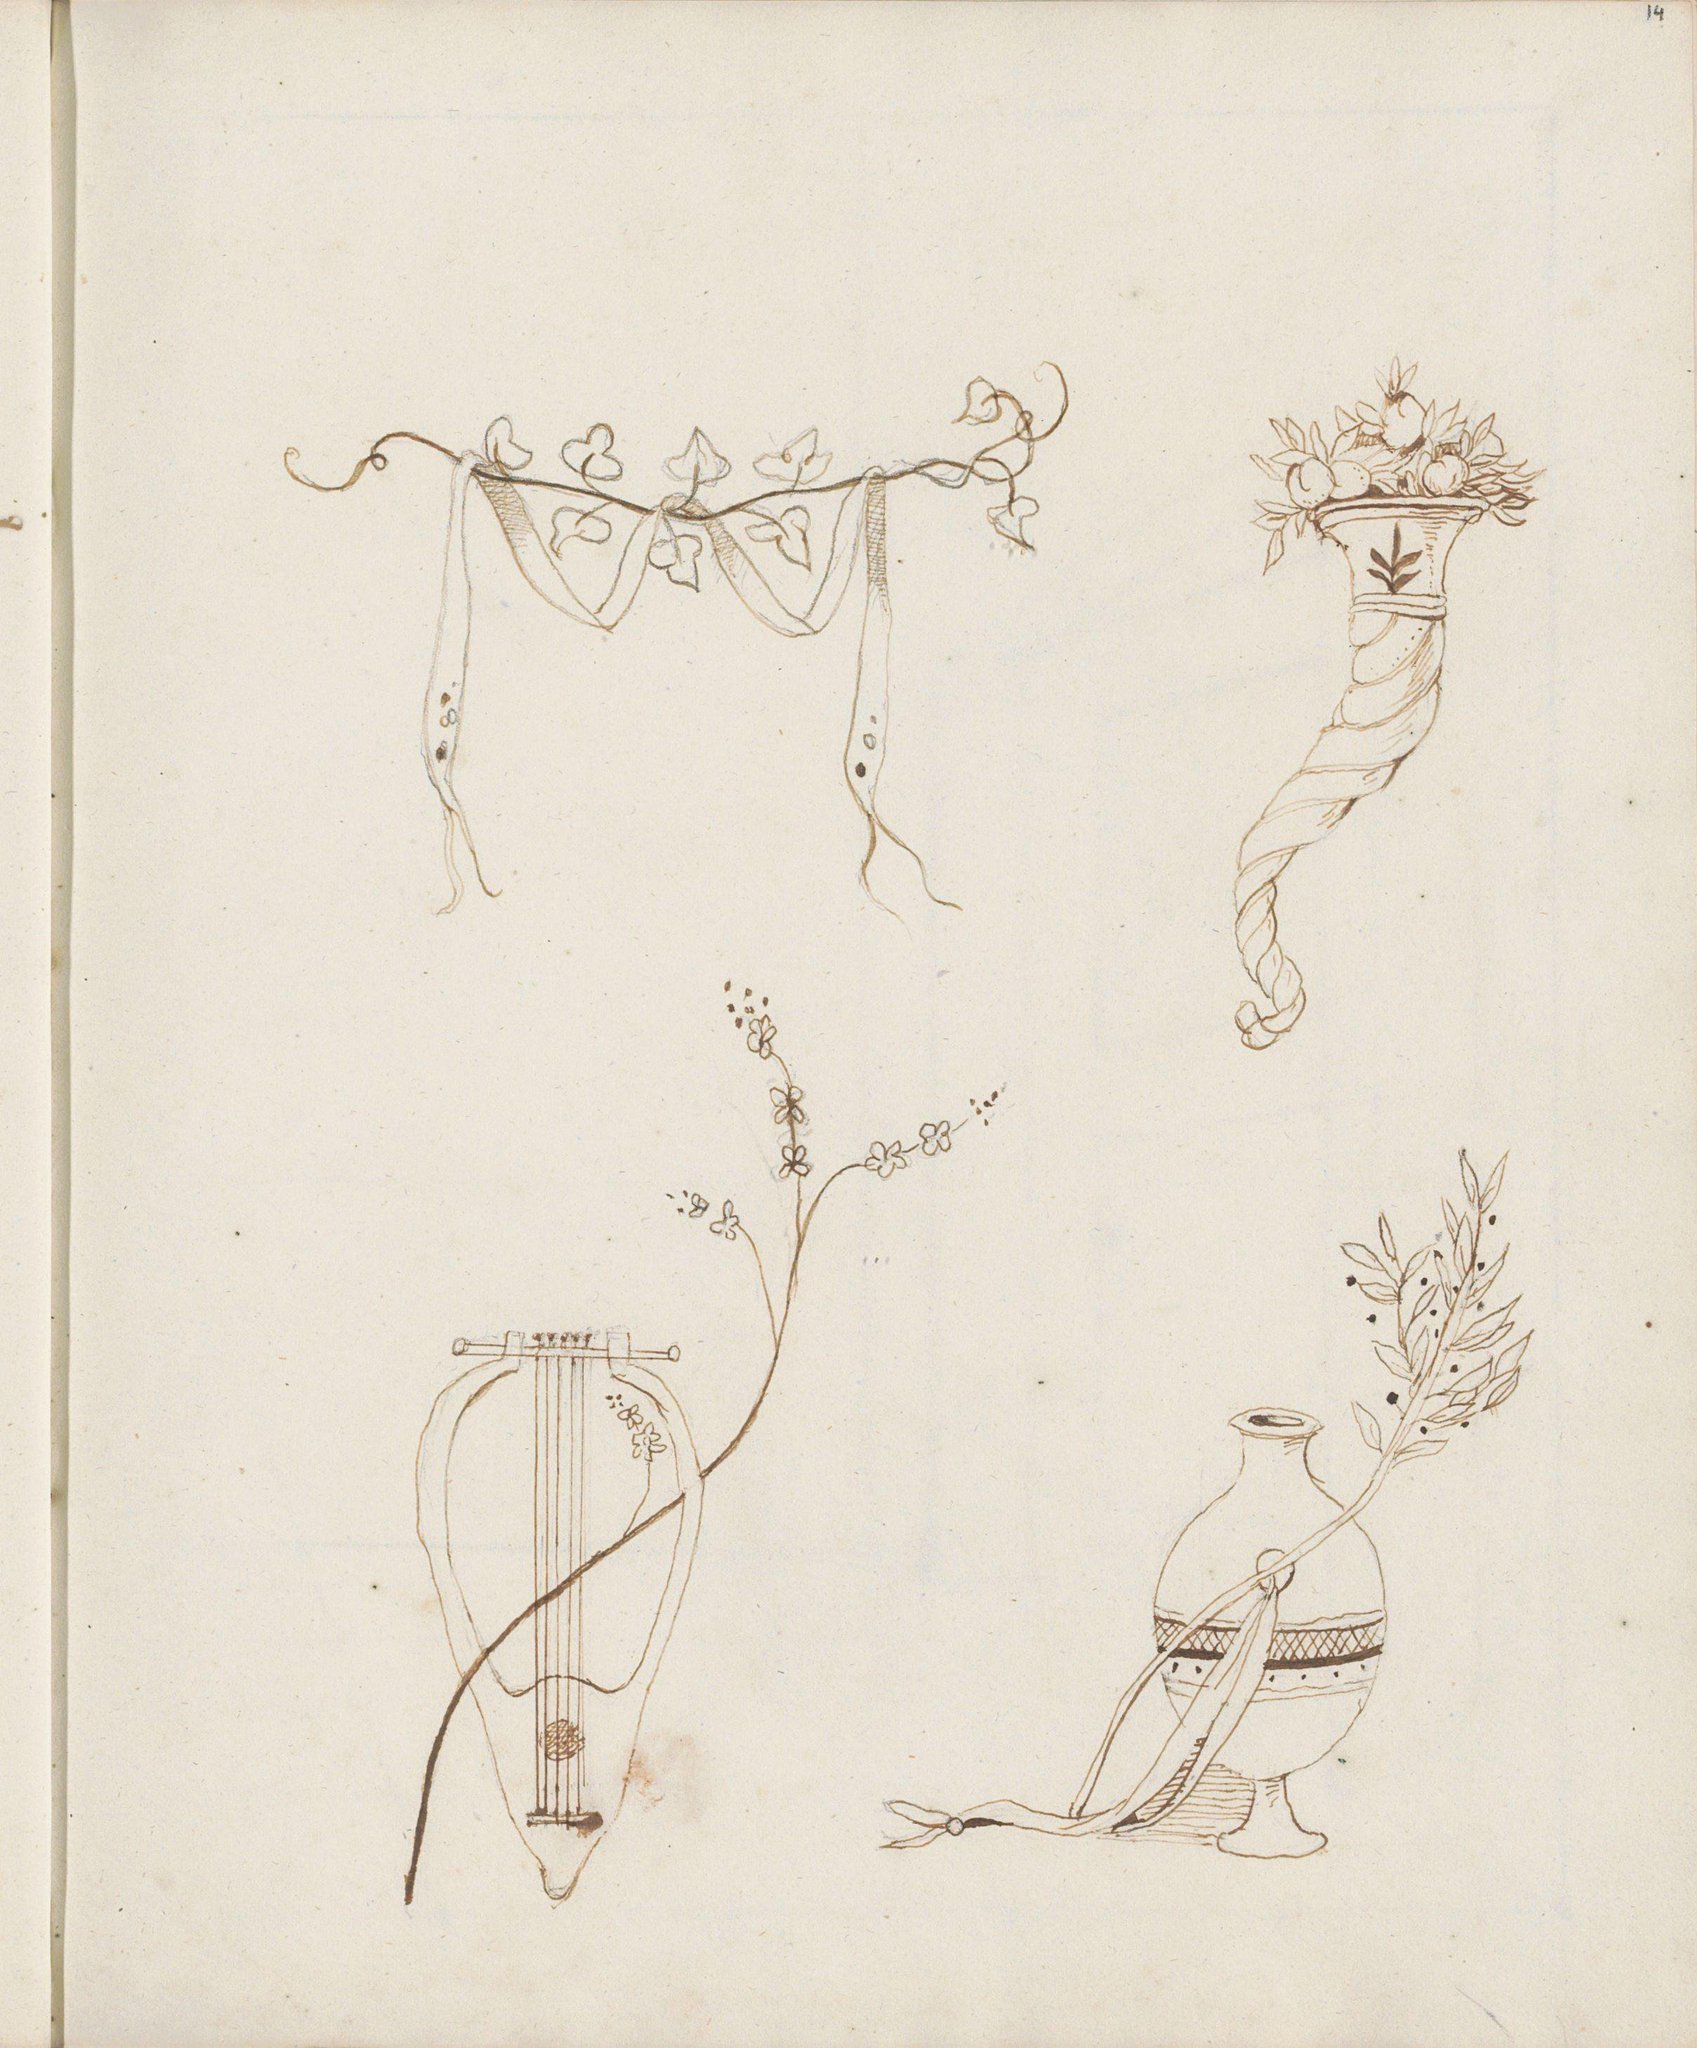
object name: sketchbook leaf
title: Guirlande, een cornucopia, een lier en een Griekse vaas met een olijftak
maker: jonkvrouw catharina kemper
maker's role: draughtsman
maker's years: 1801-1871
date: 1813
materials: ink, paper, pencil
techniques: pen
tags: 'cornucopia', horn of plenty, lyre, cithara, psaltery, garland, wreath, container of stone: stone vase, trees: olive-tree (+ branch, stick)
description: Blad 14 recto uit een schetsboek met 91 bladen.